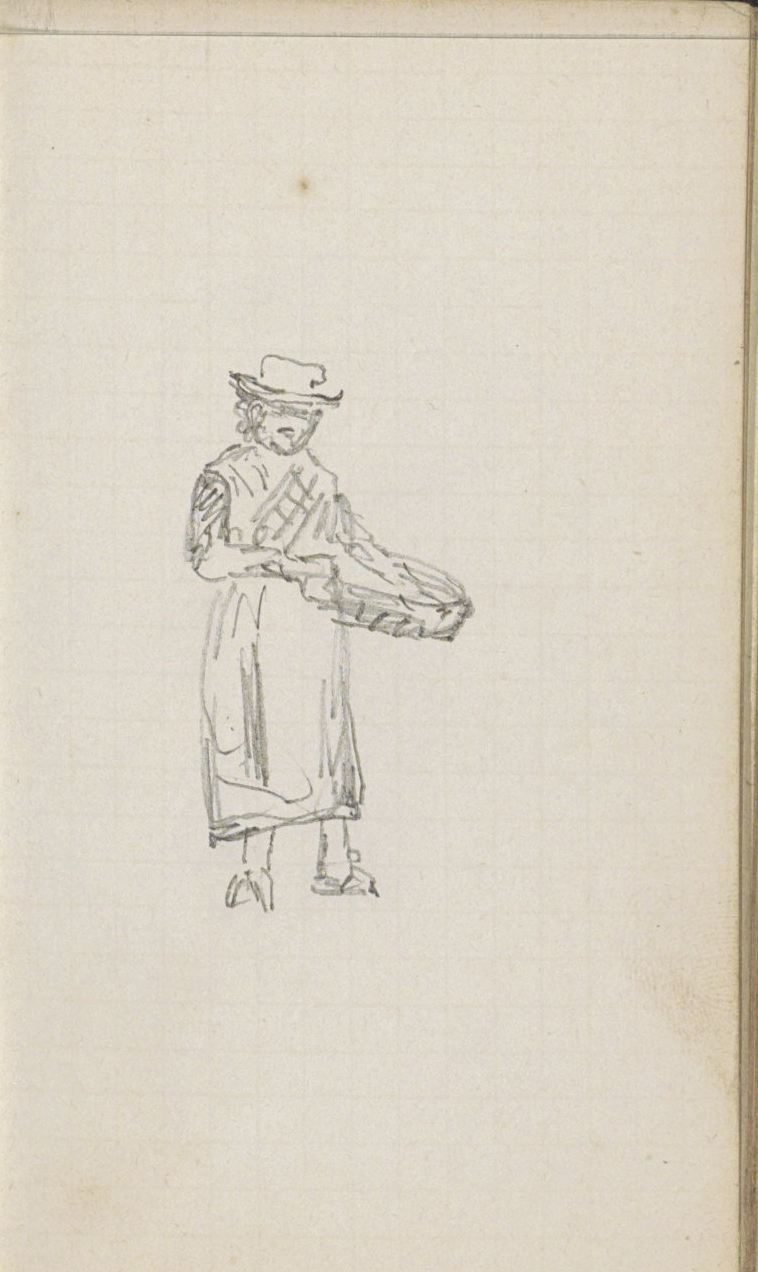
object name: sketchbook leaf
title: Staande vrouw met een mand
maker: jan willem van borselen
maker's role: draughtsman, print maker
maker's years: 1825-1892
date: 1868-1887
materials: pencil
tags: standing figure, container made of plant material other than wood: basket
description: Blad 32 recto uit een schetsboek met 51 bladen.